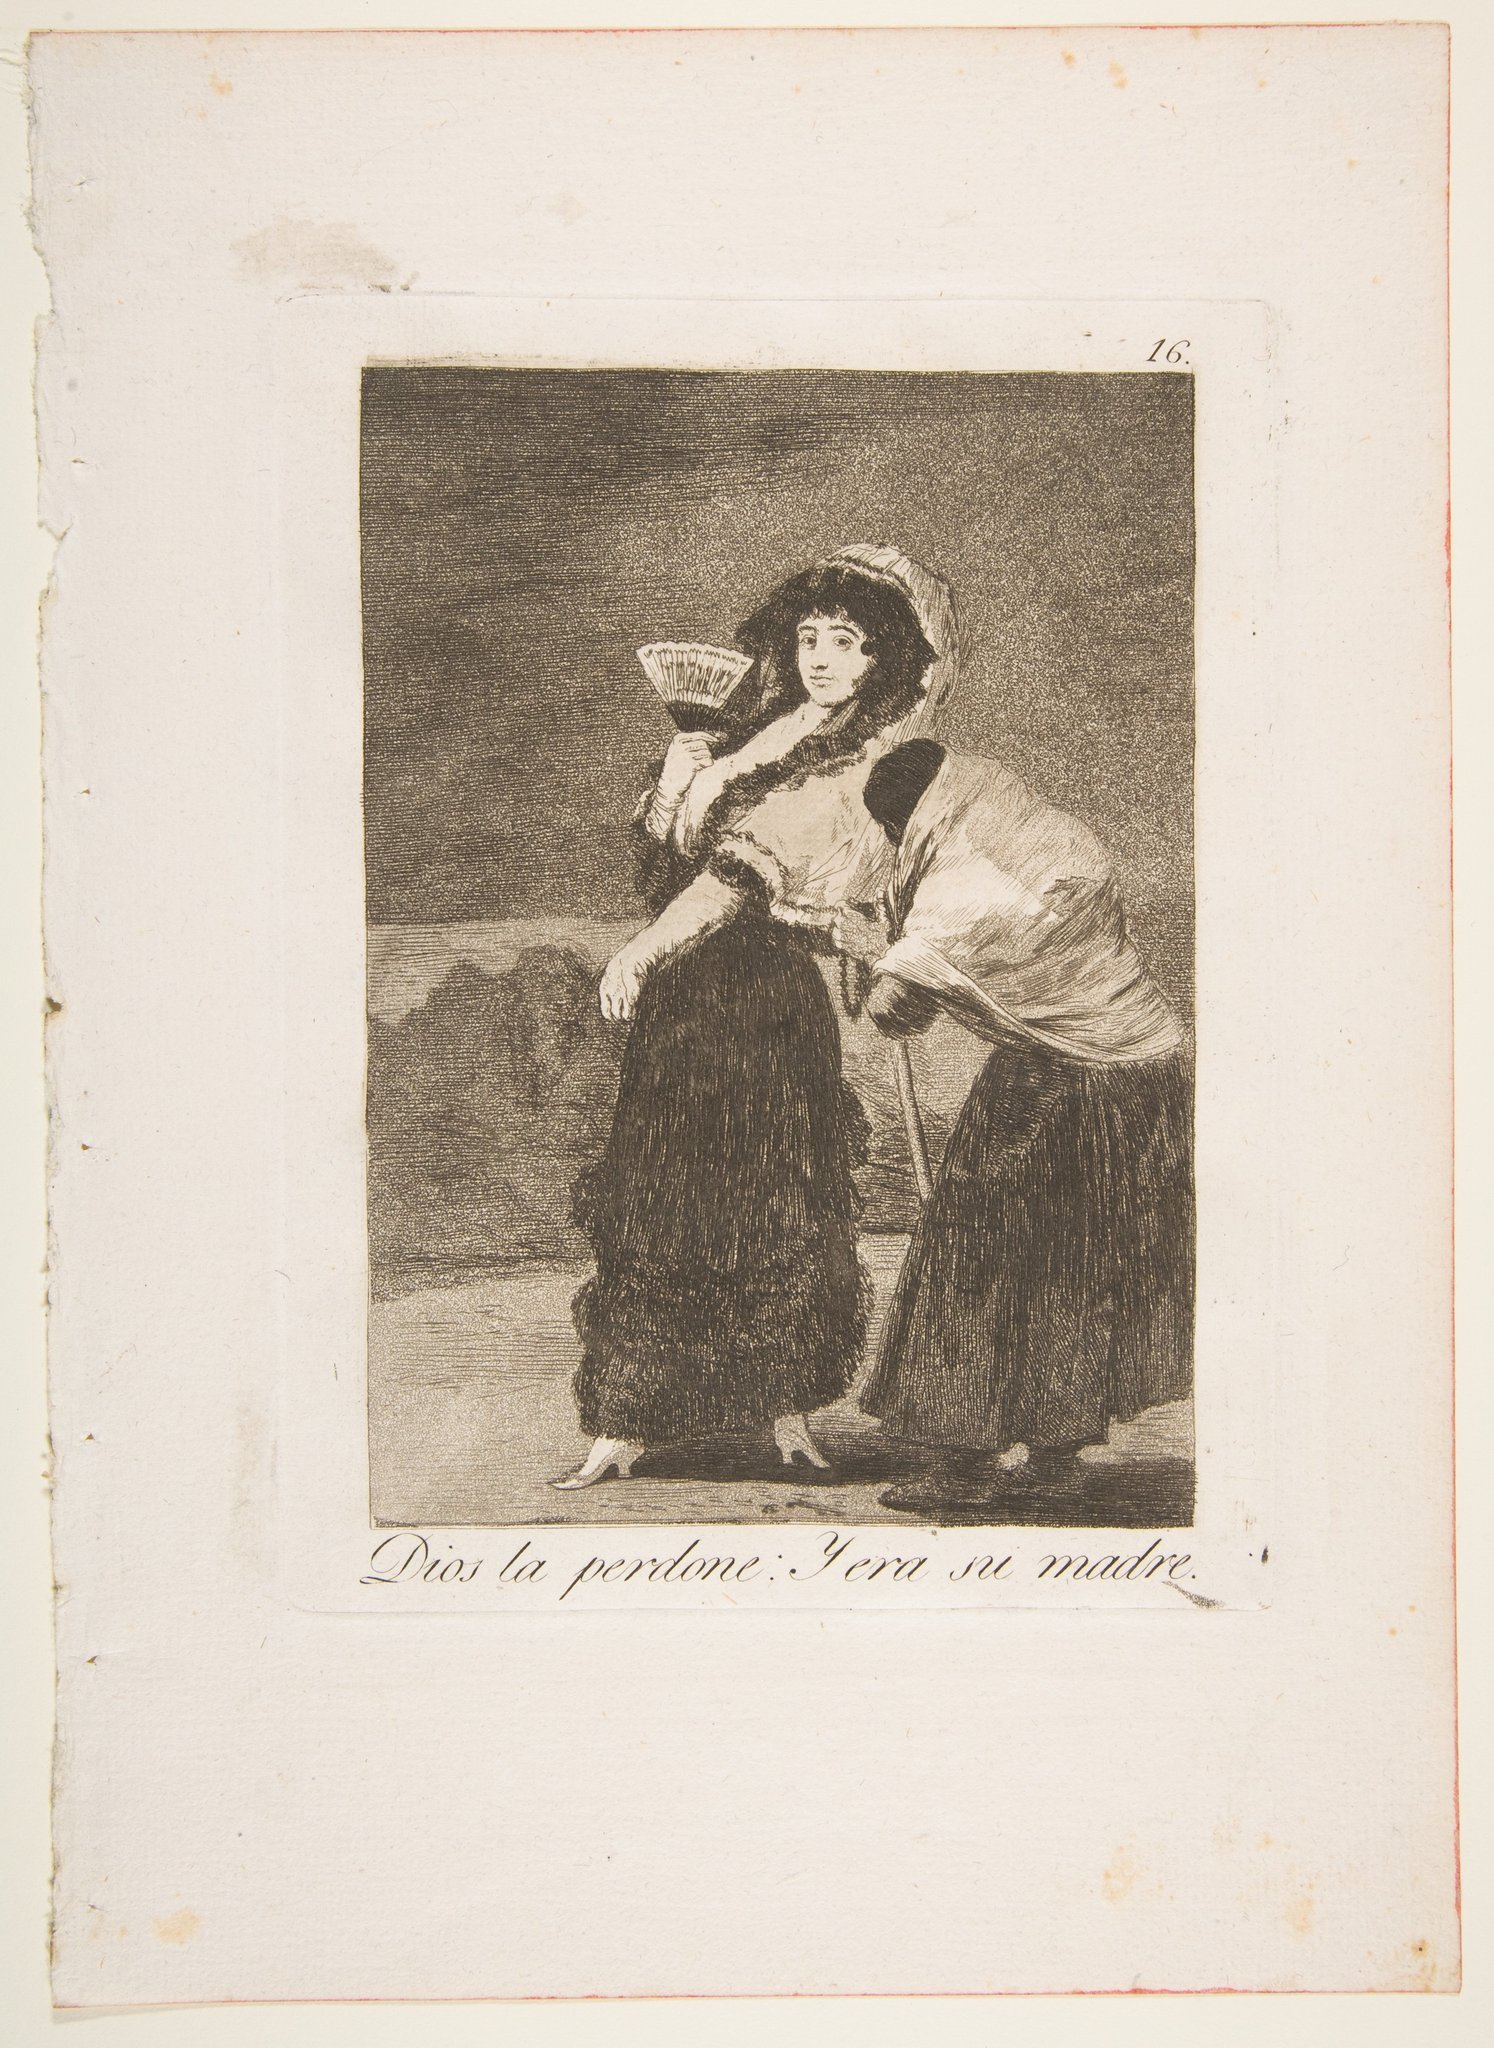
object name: print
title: Plate 16 from "Los Caprichos": For heaven's sake: and it was her mother (Dios la Perdone: Y era su madre)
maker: goya (francisco de goya y lucientes)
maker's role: artist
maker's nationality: spanish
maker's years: 1746-1828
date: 1799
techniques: aquatint, burnishing, drypoint, etching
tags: girls,mothers